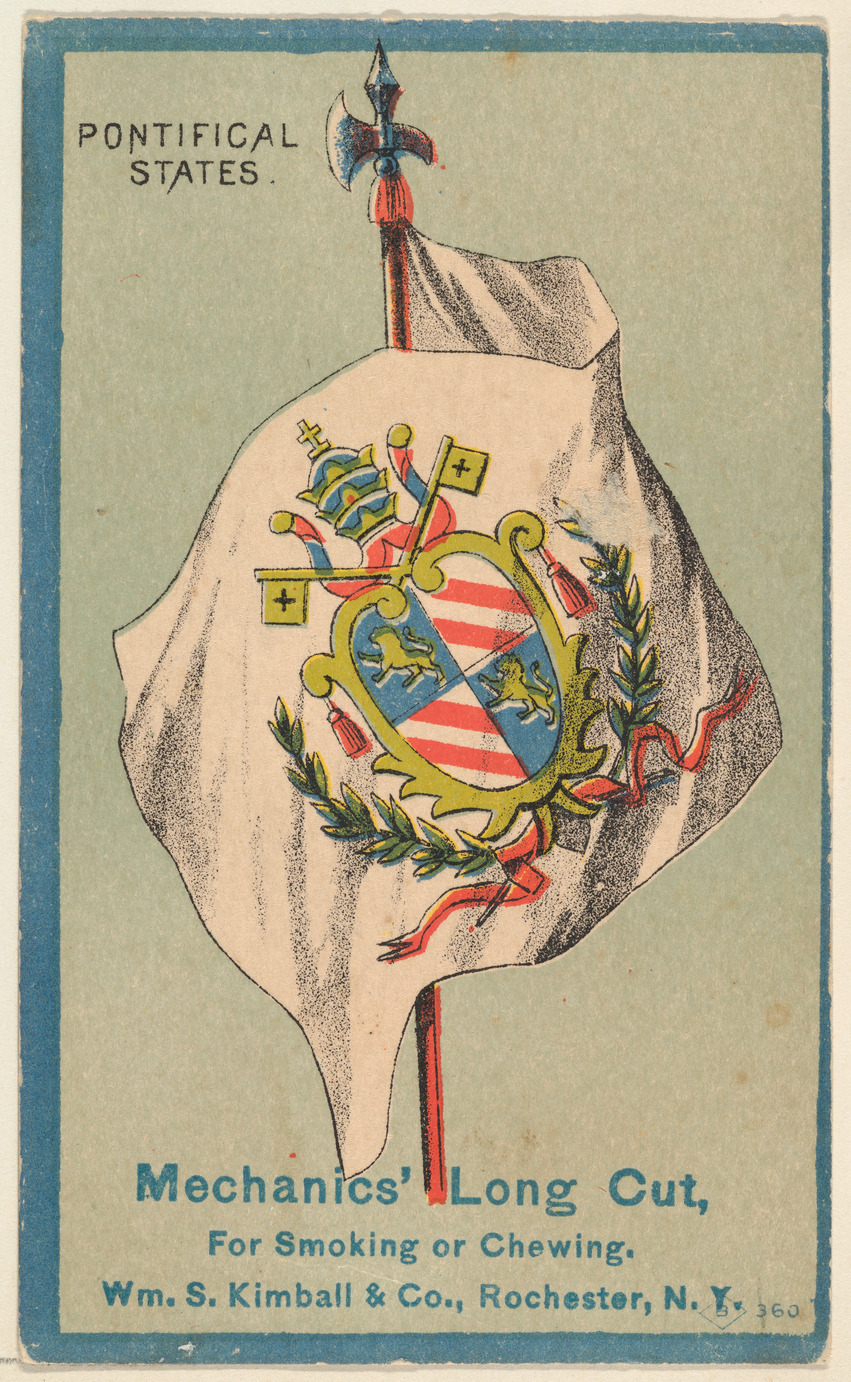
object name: print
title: Pontifical States, from the National Flags series (N195) issued by Wm. S. Kimball & Co.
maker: william s. kimball & company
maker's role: publisher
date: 1891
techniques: color lithograph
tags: coat of arms,flags